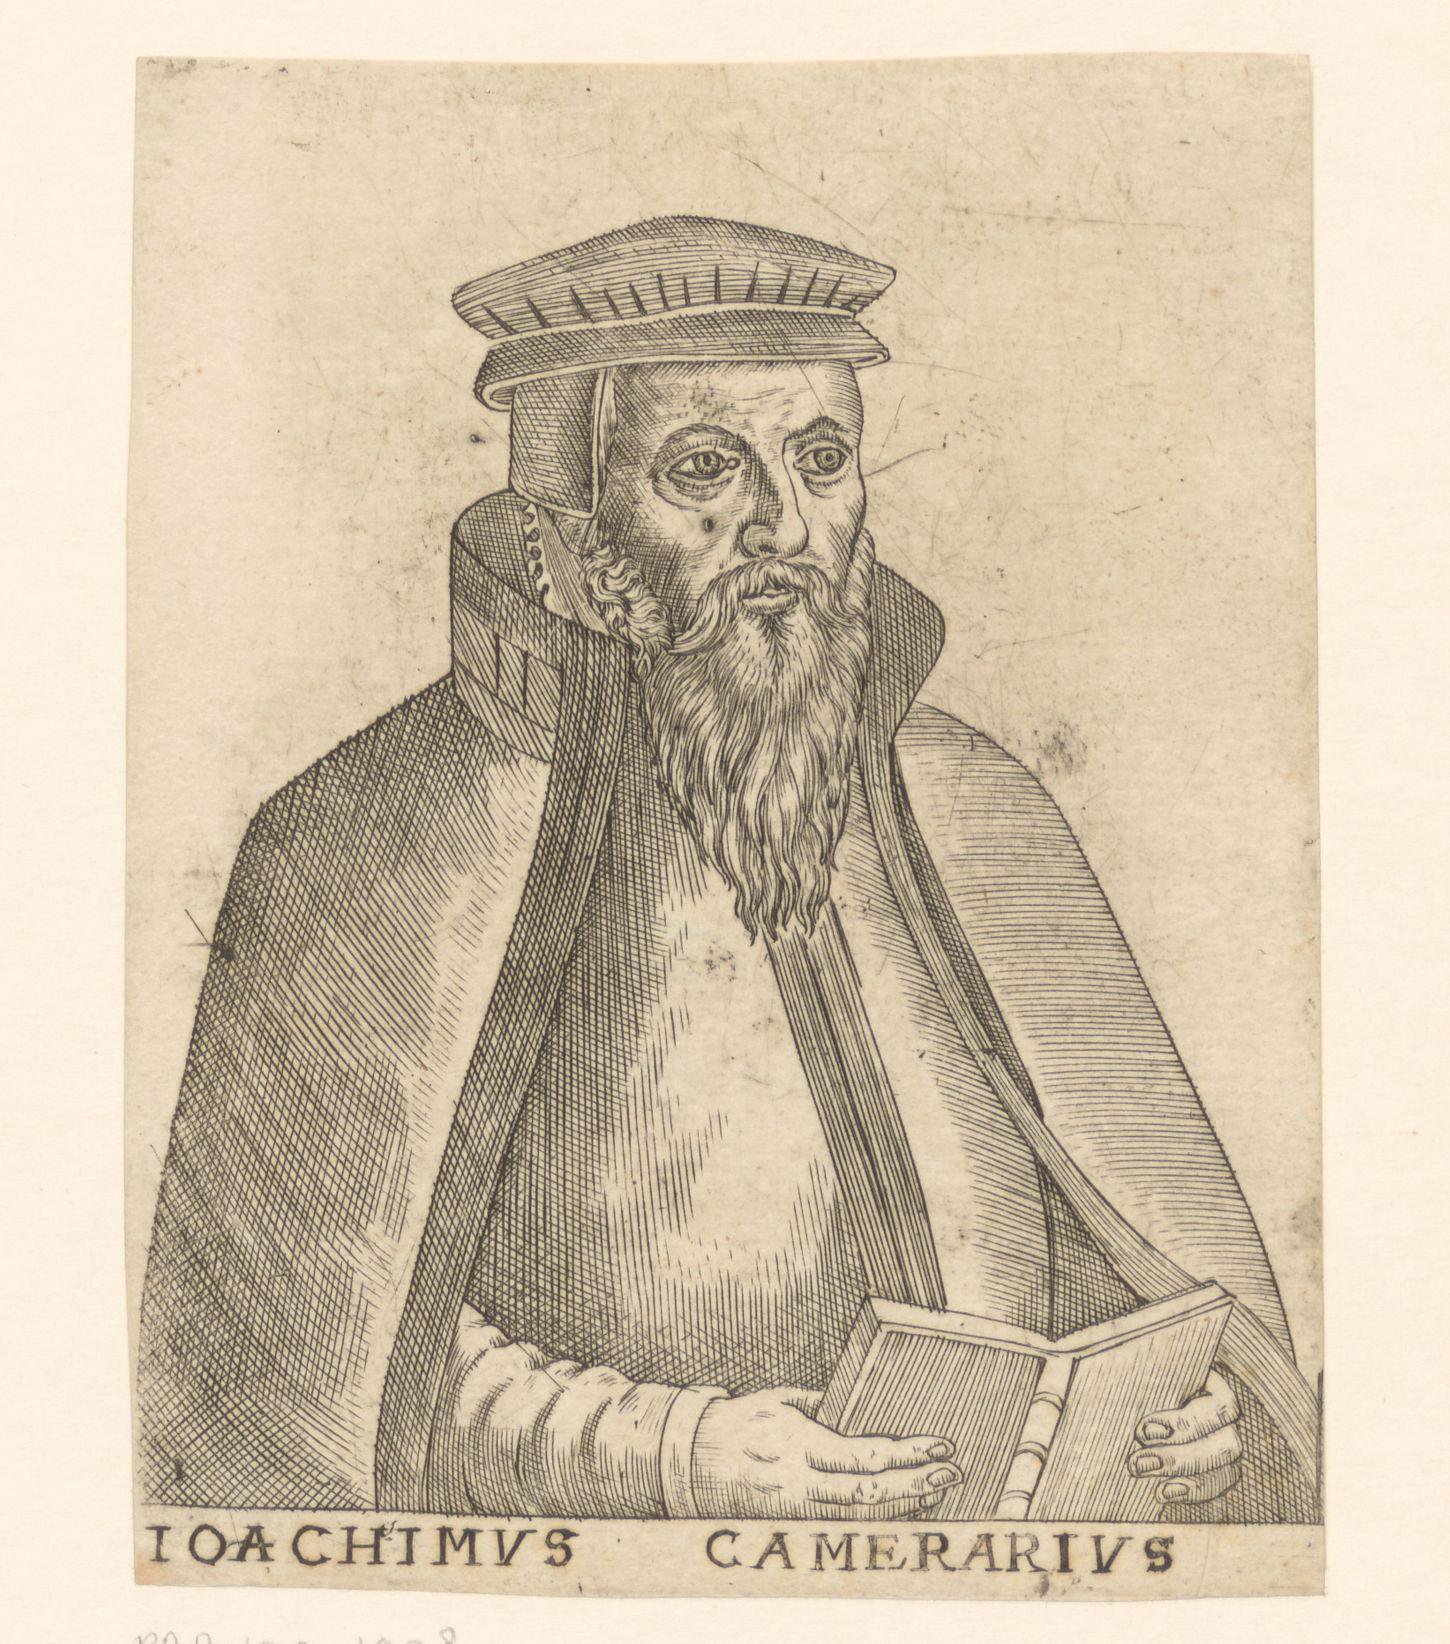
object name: print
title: Portret van Joachim Camerarius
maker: Anonymous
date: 1563-1642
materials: paper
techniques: engraving, etching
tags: theologian, historical persons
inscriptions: collector's mark: Lugt 2228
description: Deze prent (een impressie) hoort bij een serie portretten van sturende personen tijdens de reformatie.